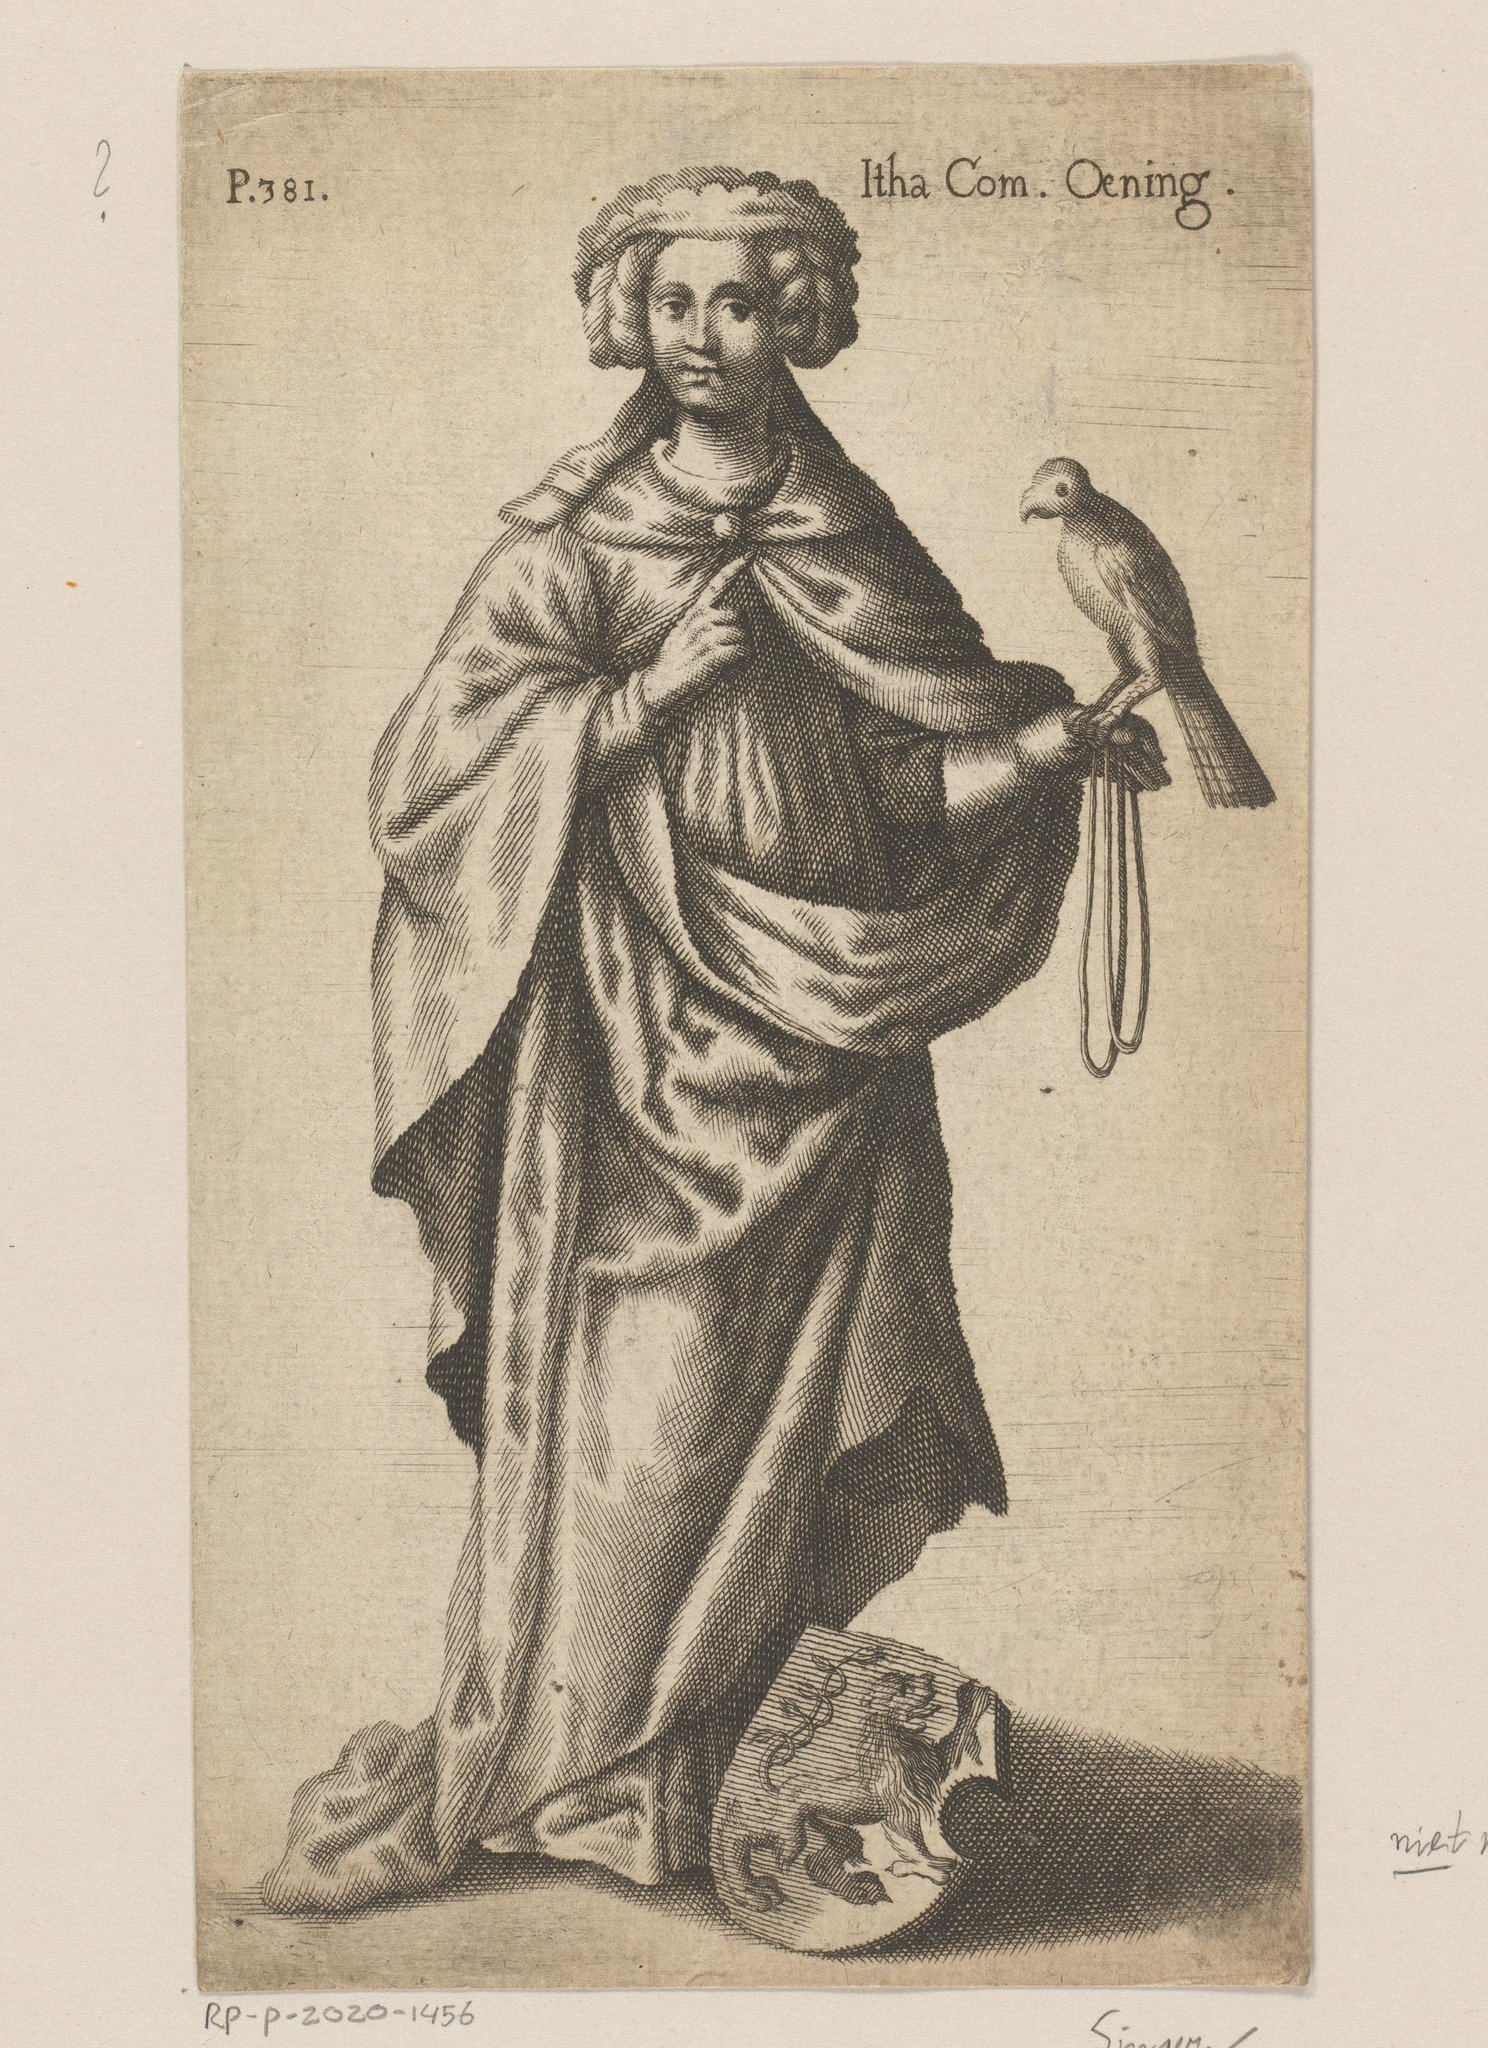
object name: print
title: Itha. com. Oening.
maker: Anonymous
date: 1550-1649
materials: paper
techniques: engraving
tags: armorial bearing, heraldry - aa - female, standing figure, birds, historical persons, dress, gown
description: Ten voeten uit en met een vogel op haar linkerhand. Aan haar voeten ligt een wapenschild. Rechtsboven genummerd: p.381.